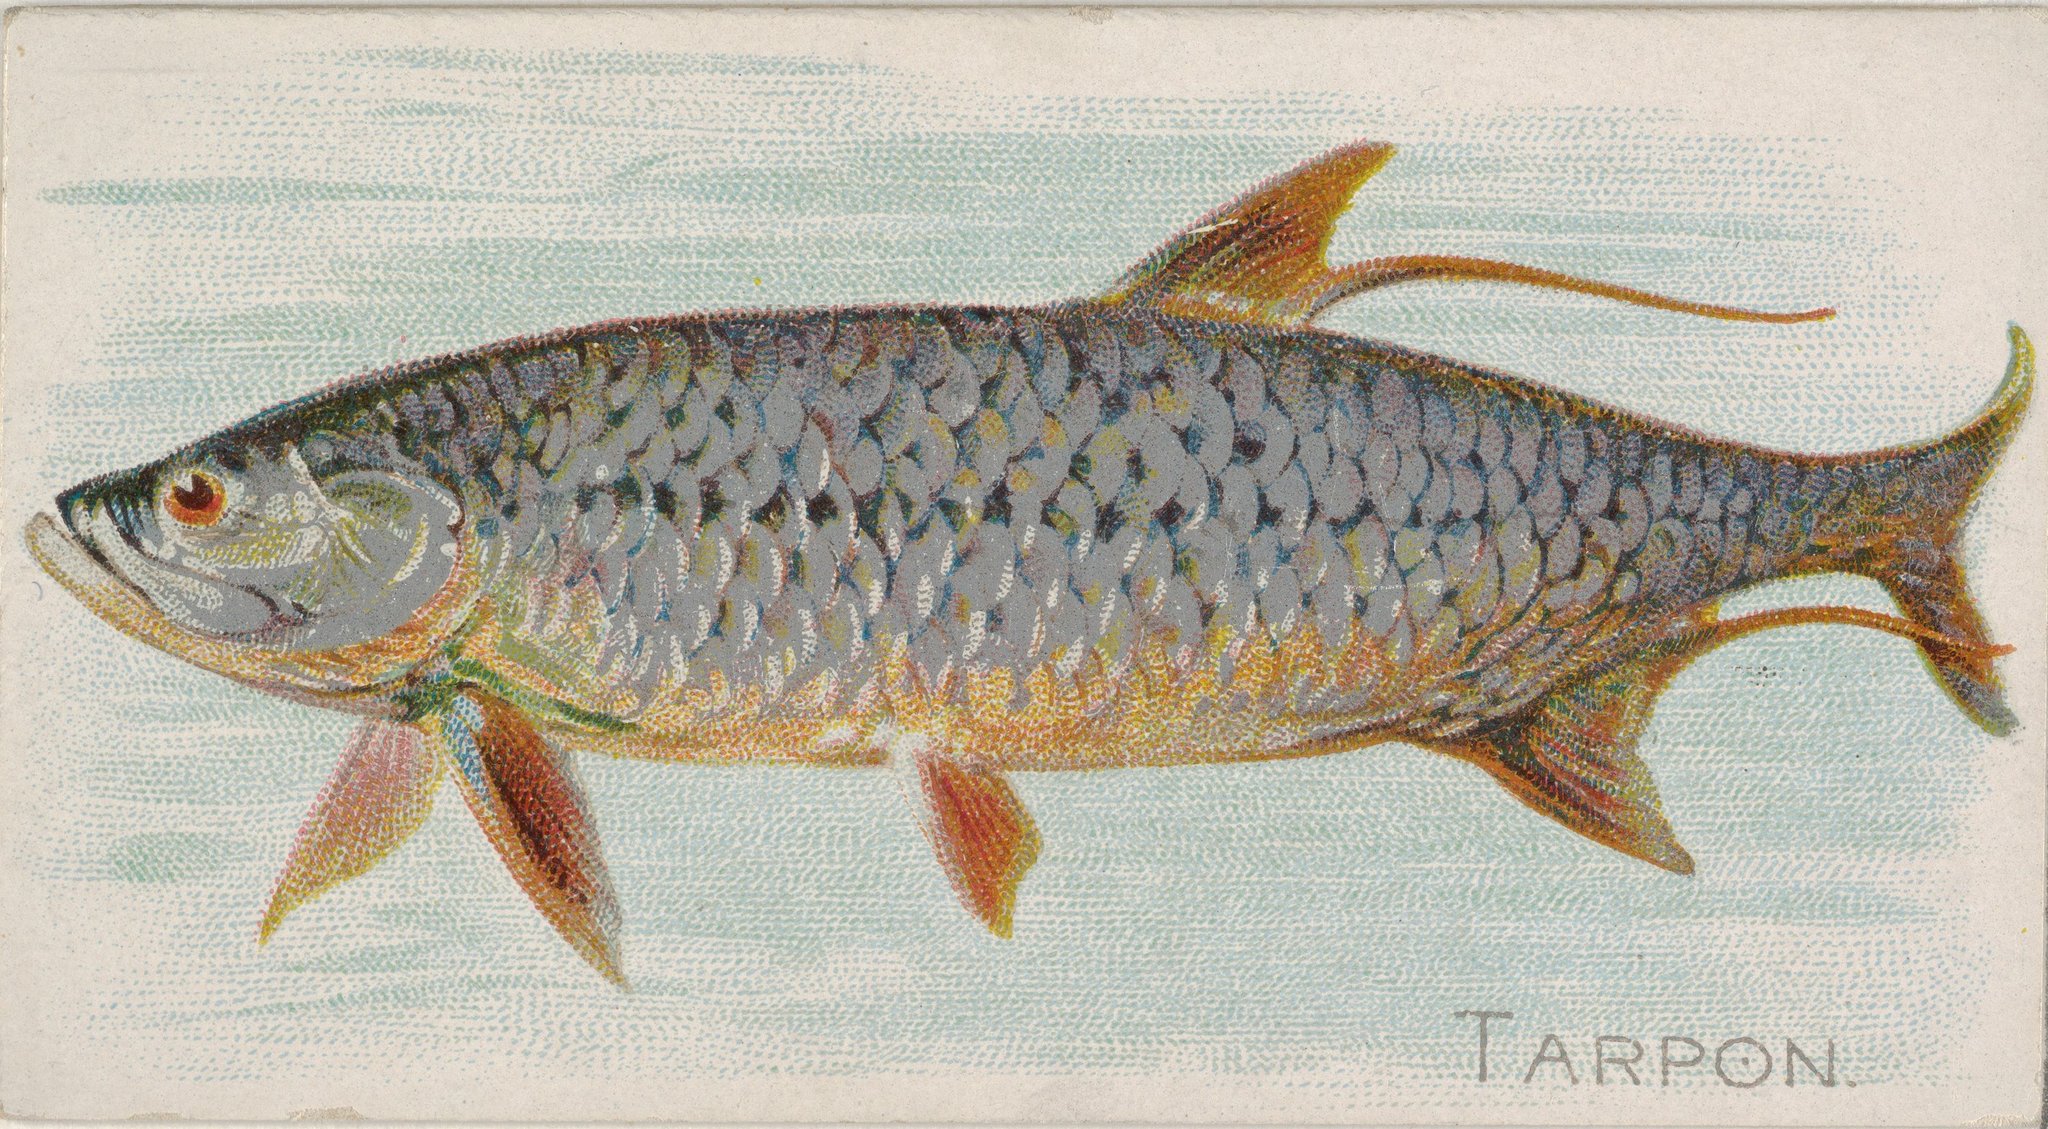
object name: print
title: Tarpon, from the Fish from American Waters series (N8) for Allen & Ginter Cigarettes Brands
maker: allen & ginter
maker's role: publisher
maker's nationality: american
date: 1889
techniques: color lithograph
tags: fish